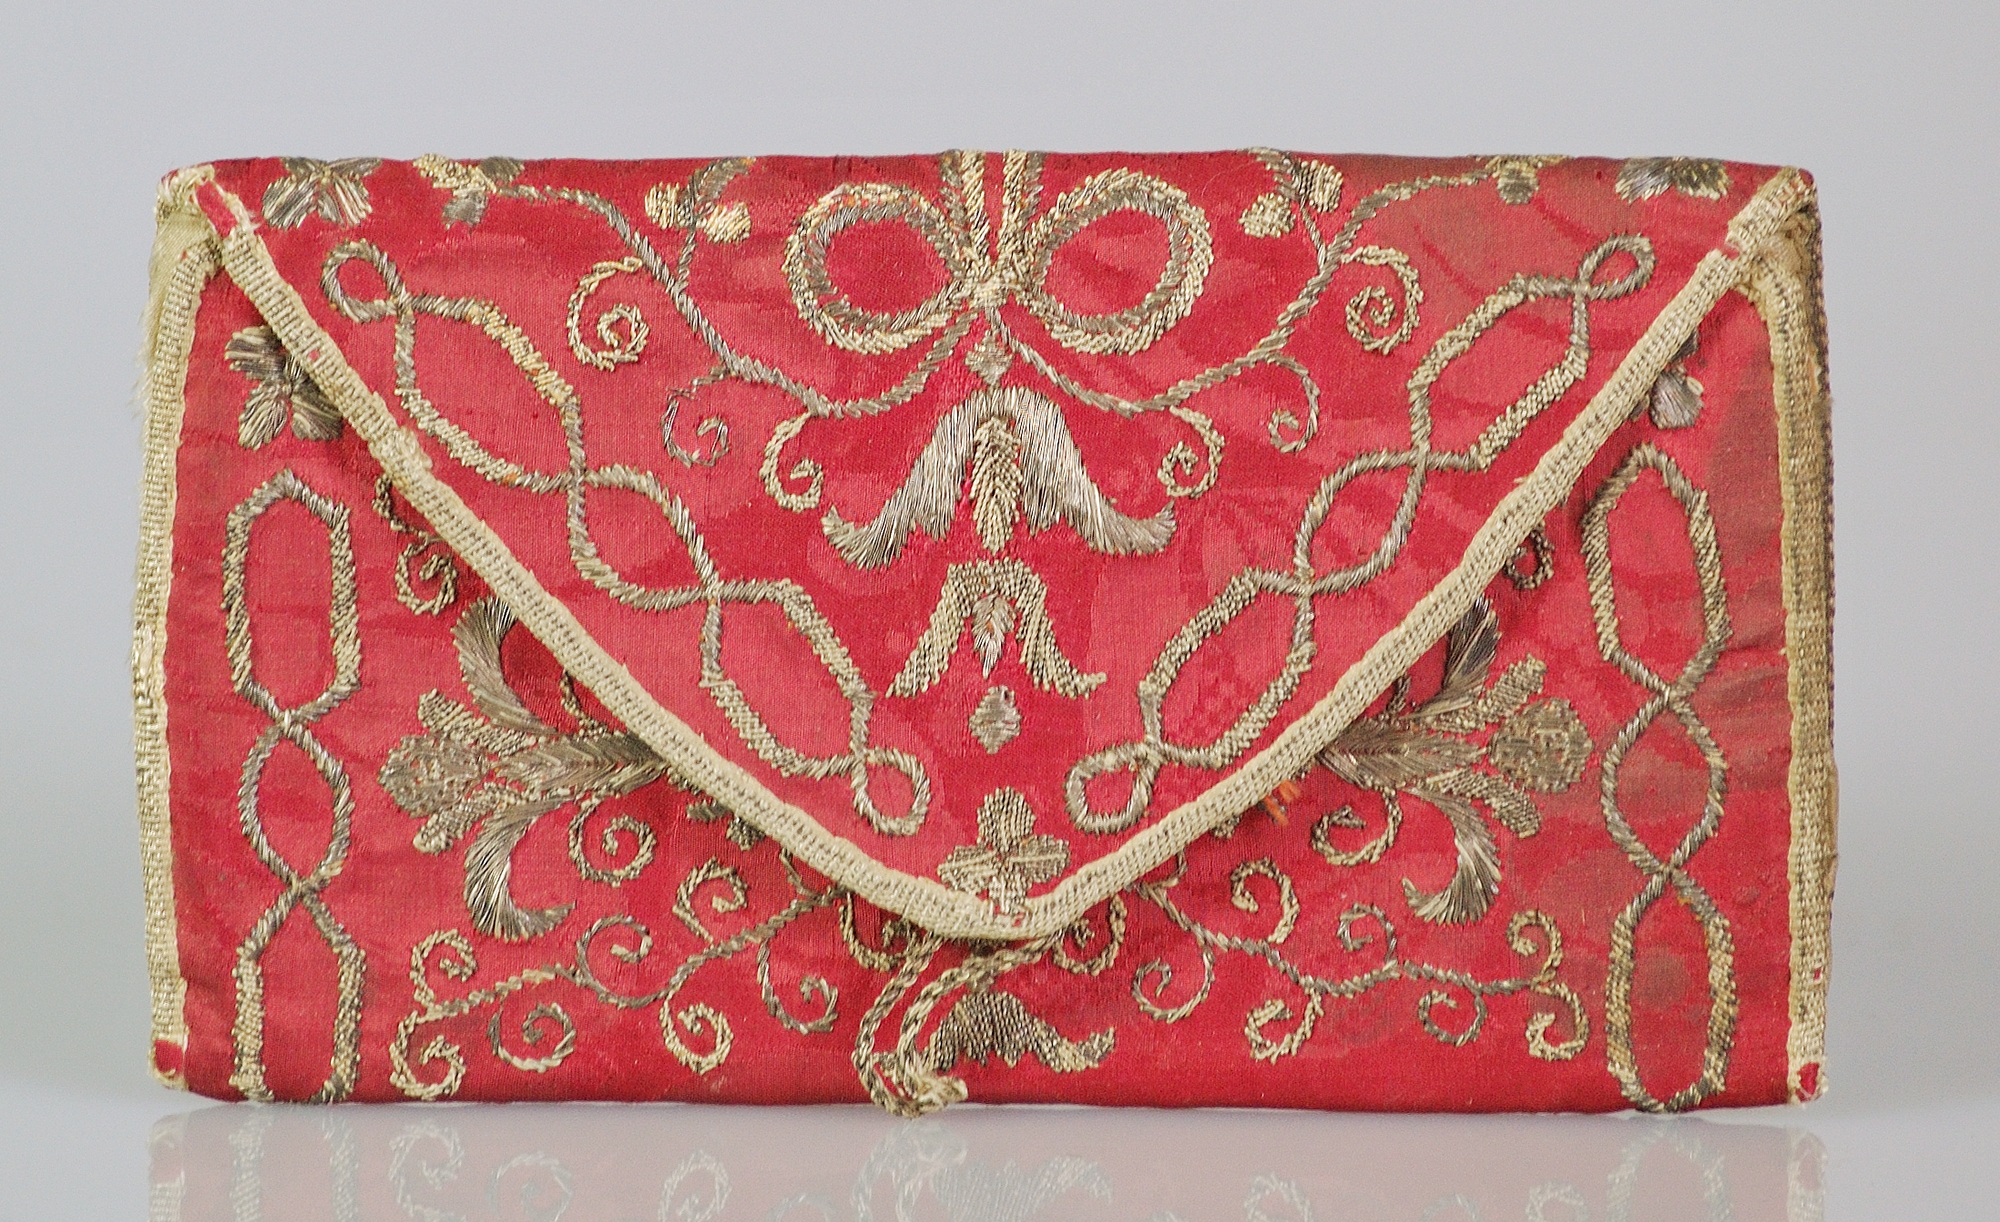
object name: bag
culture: european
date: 1740-1770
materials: metal, silk